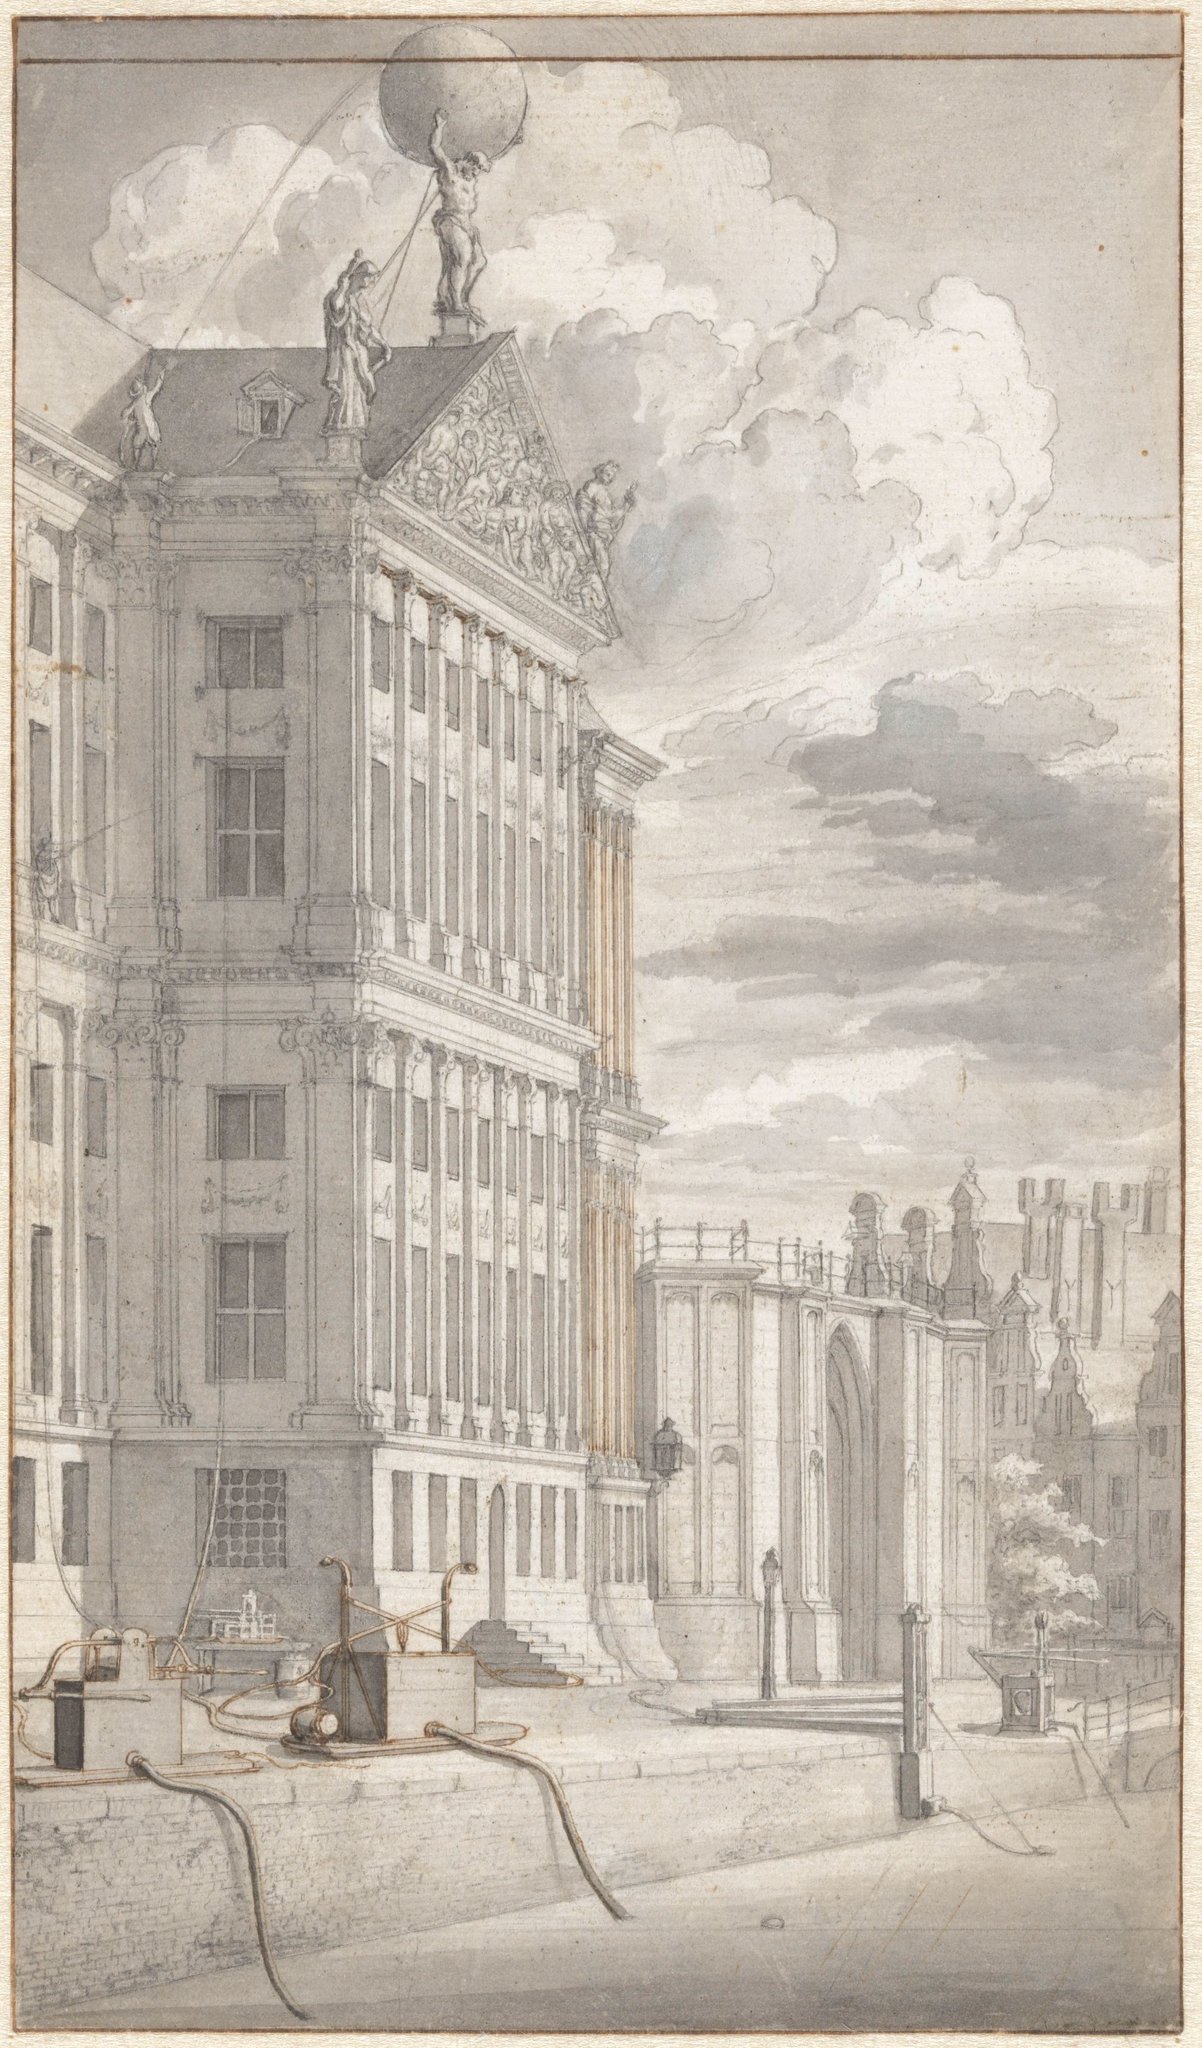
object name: drawing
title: Demonstratie van de slangbrandspuit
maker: jan van der heyden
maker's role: draughtsman, painter, print maker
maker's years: 1637-1712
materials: ink, paper, pencil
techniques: brush, pen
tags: pump (fire-extinguishing equipment), fire-hose, firemen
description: Gezicht op de achterzijde van het Paleis met een demonstratie van de slangbrandspuit zoals vertoond in 1672 en 1673. Ontwerp voor een prent.